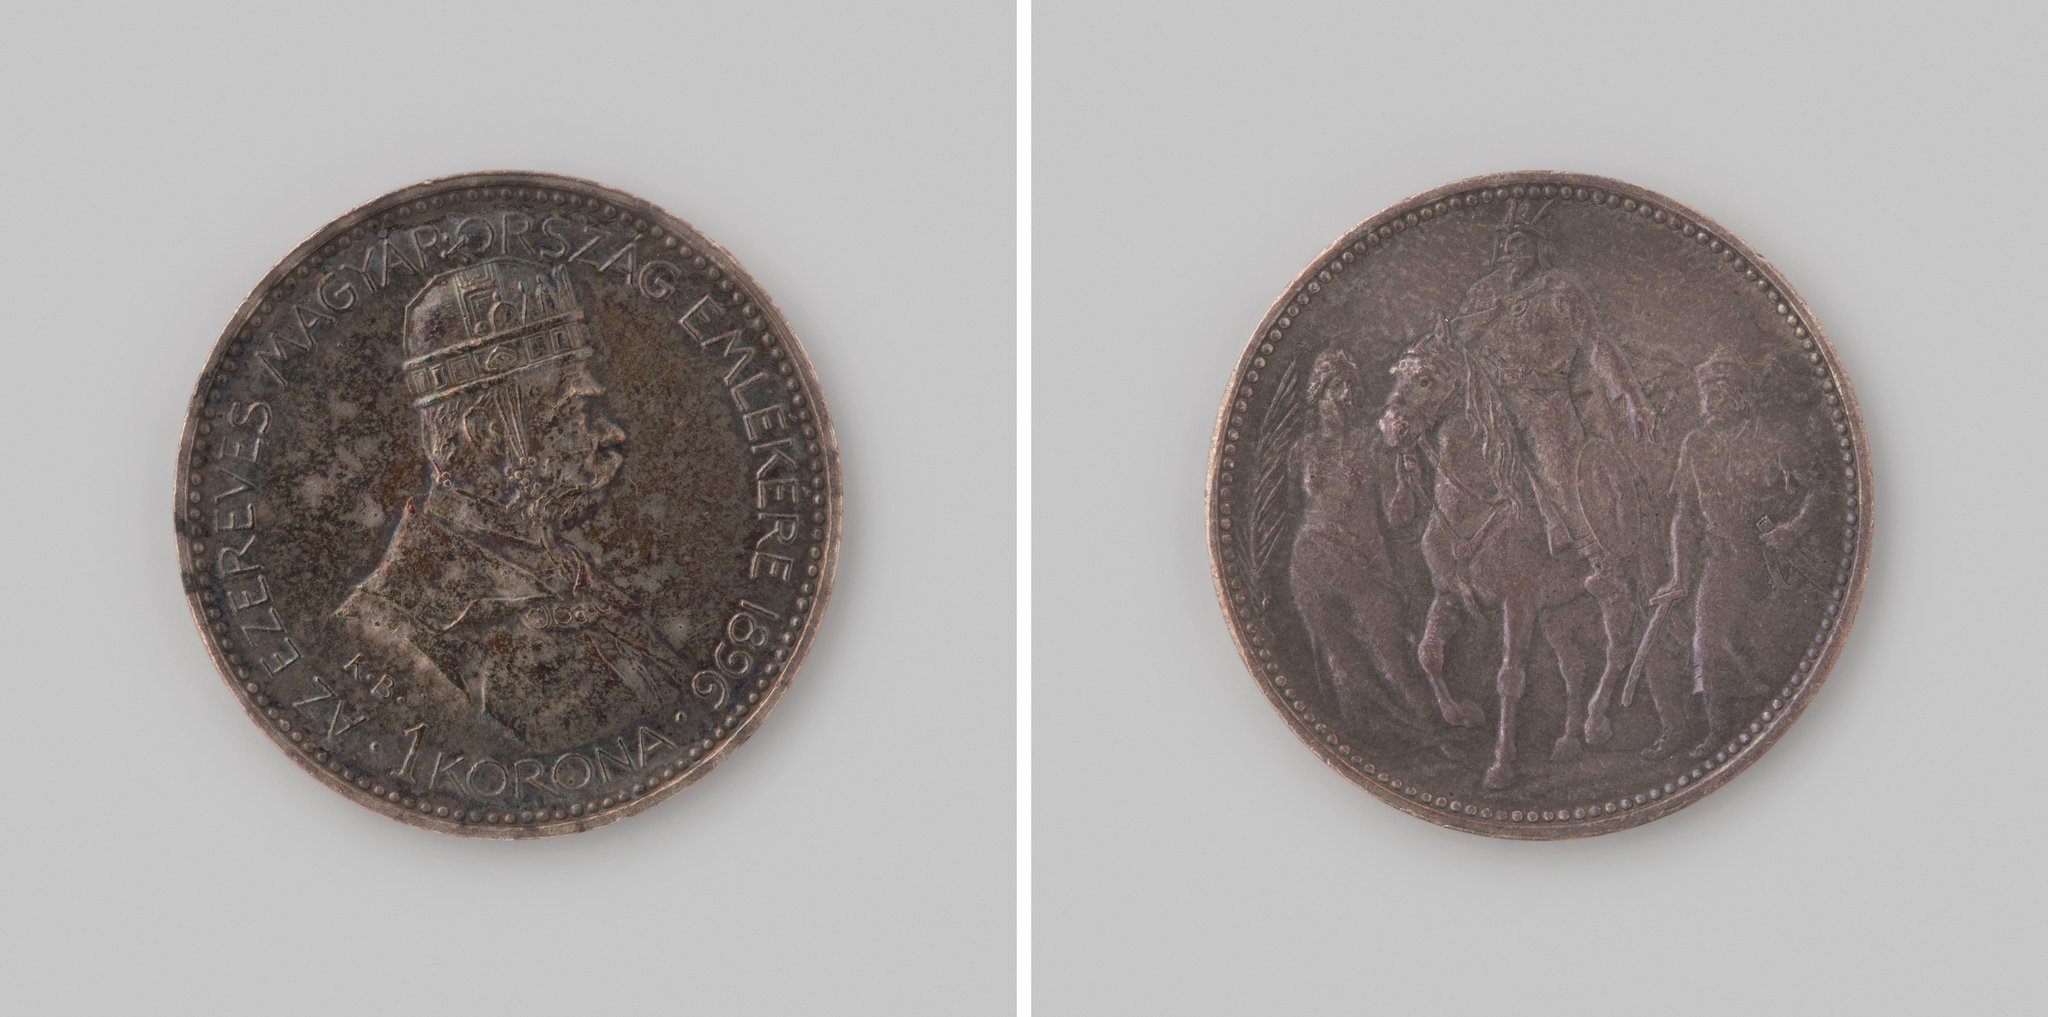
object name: corona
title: Hongarije, keizer Franz Joseph, corona, 1896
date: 1871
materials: silver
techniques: striking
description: Zilveren munt ter gelegenheid van 1000-jarig bestaan van Hongarije. Voorzijde: gekroond borstbeeld van de vorst naar rechts. Daaronder in omschrift waarde-aanduiding en jaartal. Keerzijde: vorst te paard tenmidden van onderdanen. Randschrift.